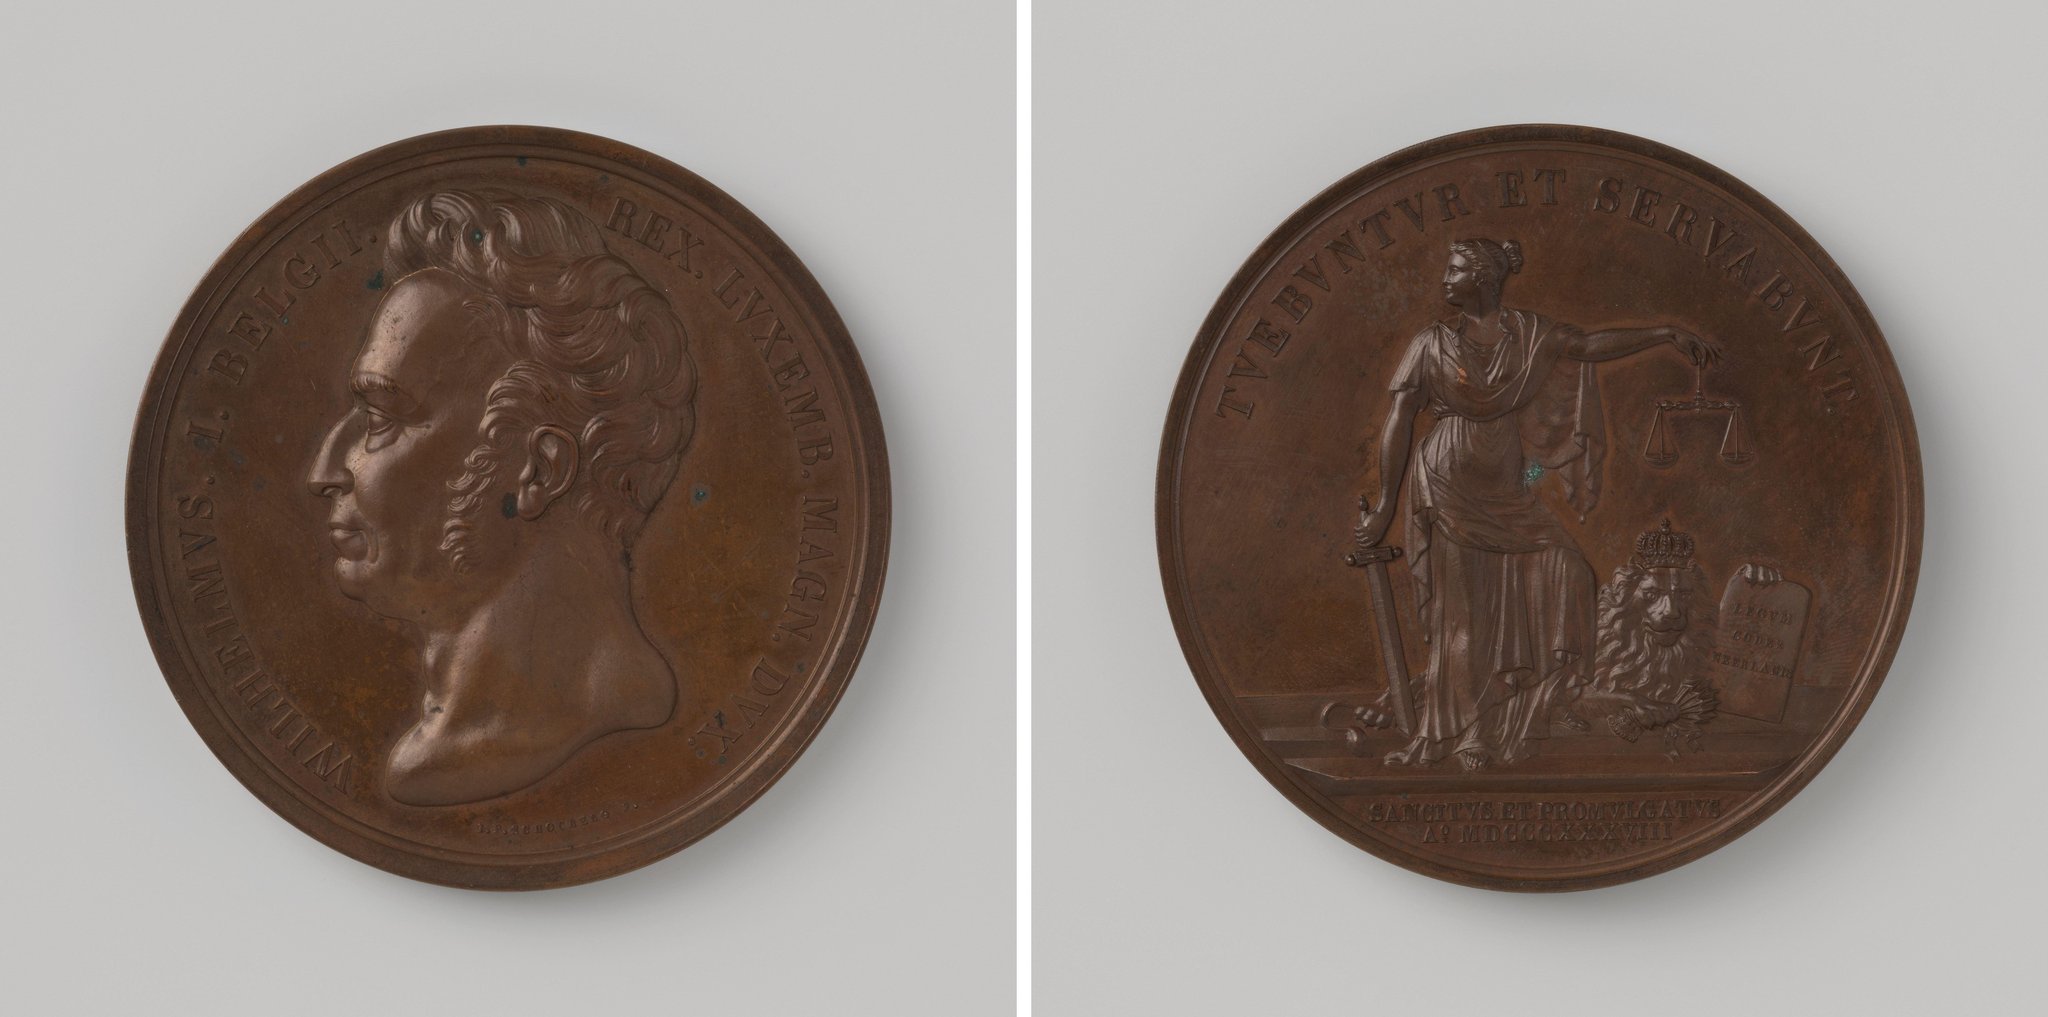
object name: history medal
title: Invoering van de nieuwe Nederlandse wetboeken 1838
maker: johannis petrus schouberg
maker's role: die cutter, draughtsman, print maker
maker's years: 1798-1864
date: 1838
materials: bronze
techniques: striking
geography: utrecht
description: Bronzen penning, op de voorzijde het portret van Koning Willem I naar links met omschrift, op de keerzijde Justitia met weegschaal en zwaard naast de gekroonde Nederlandse leeuw met pijlenbundel, een poot op een wetstafel, met omschrift en afsnedetekst.